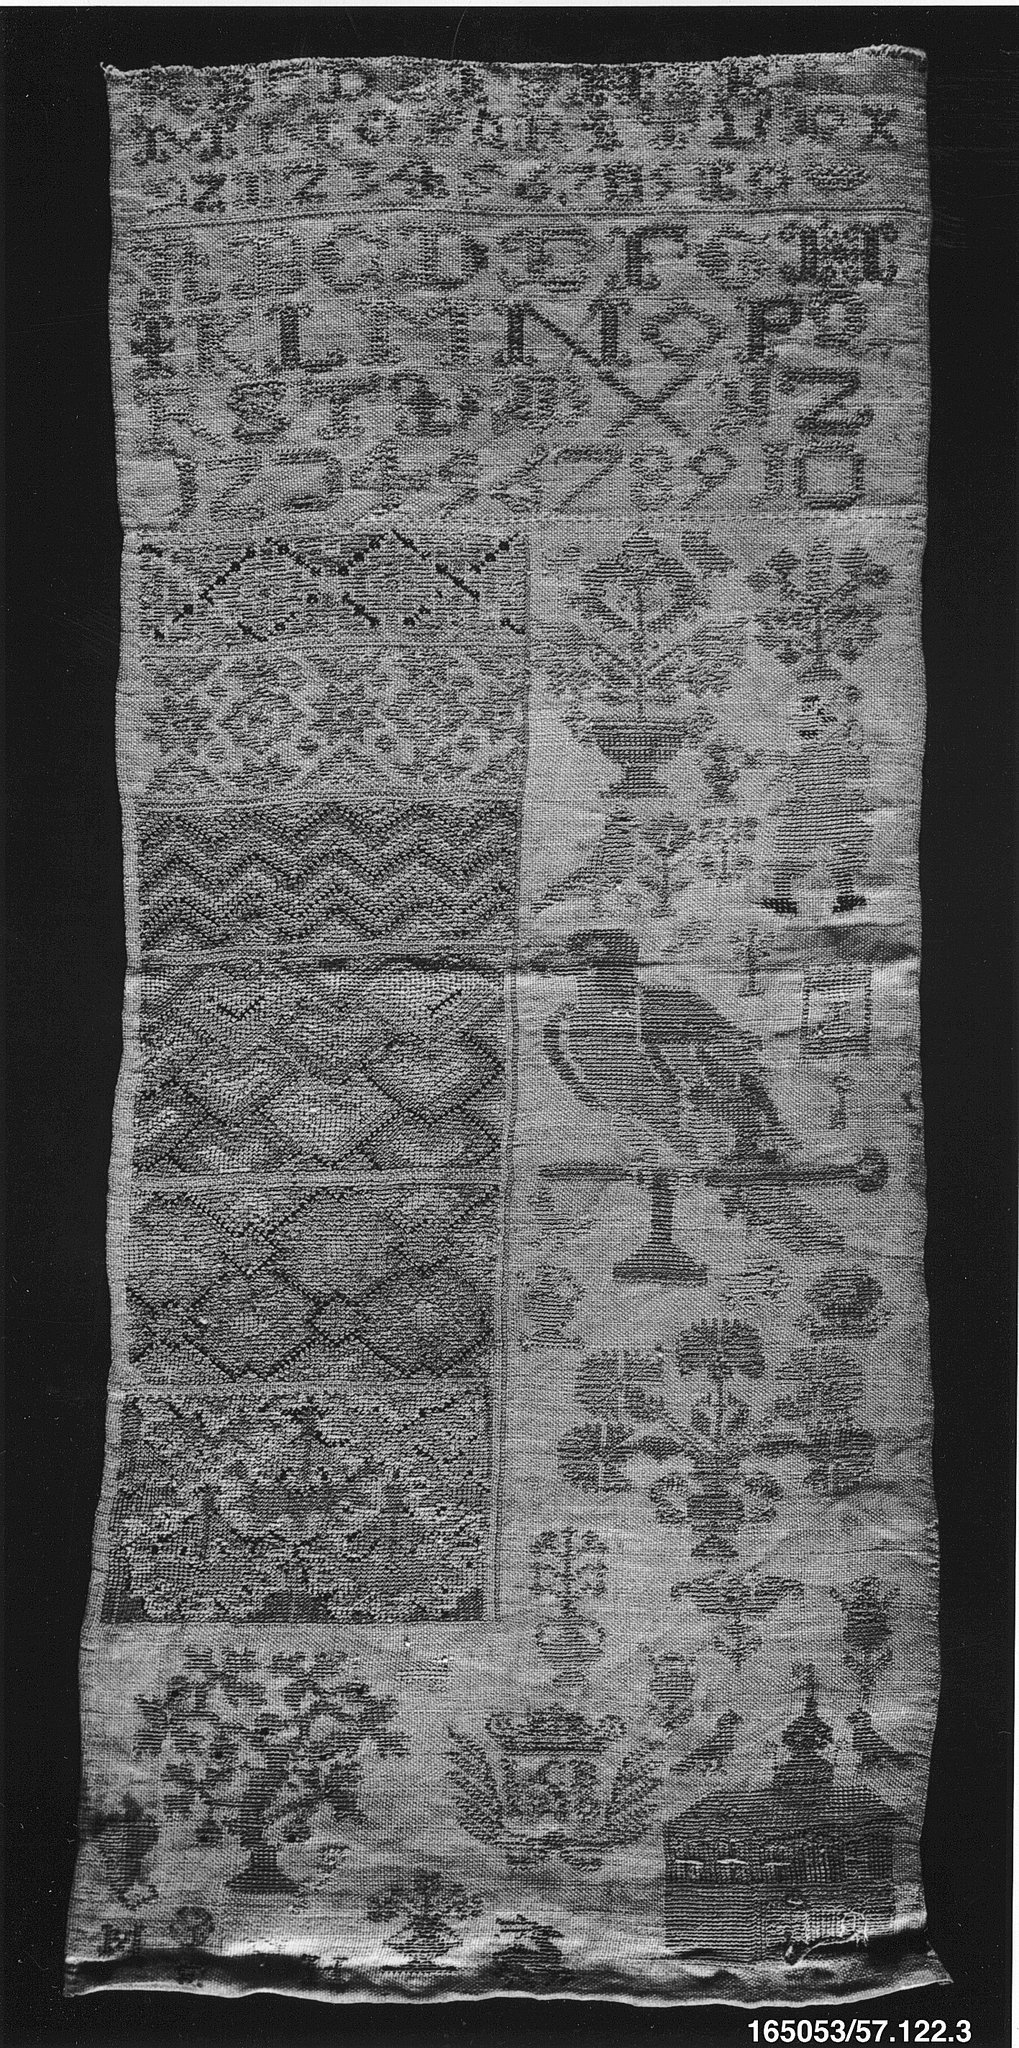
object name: sampler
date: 1730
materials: linen, silk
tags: birds,coat of arms